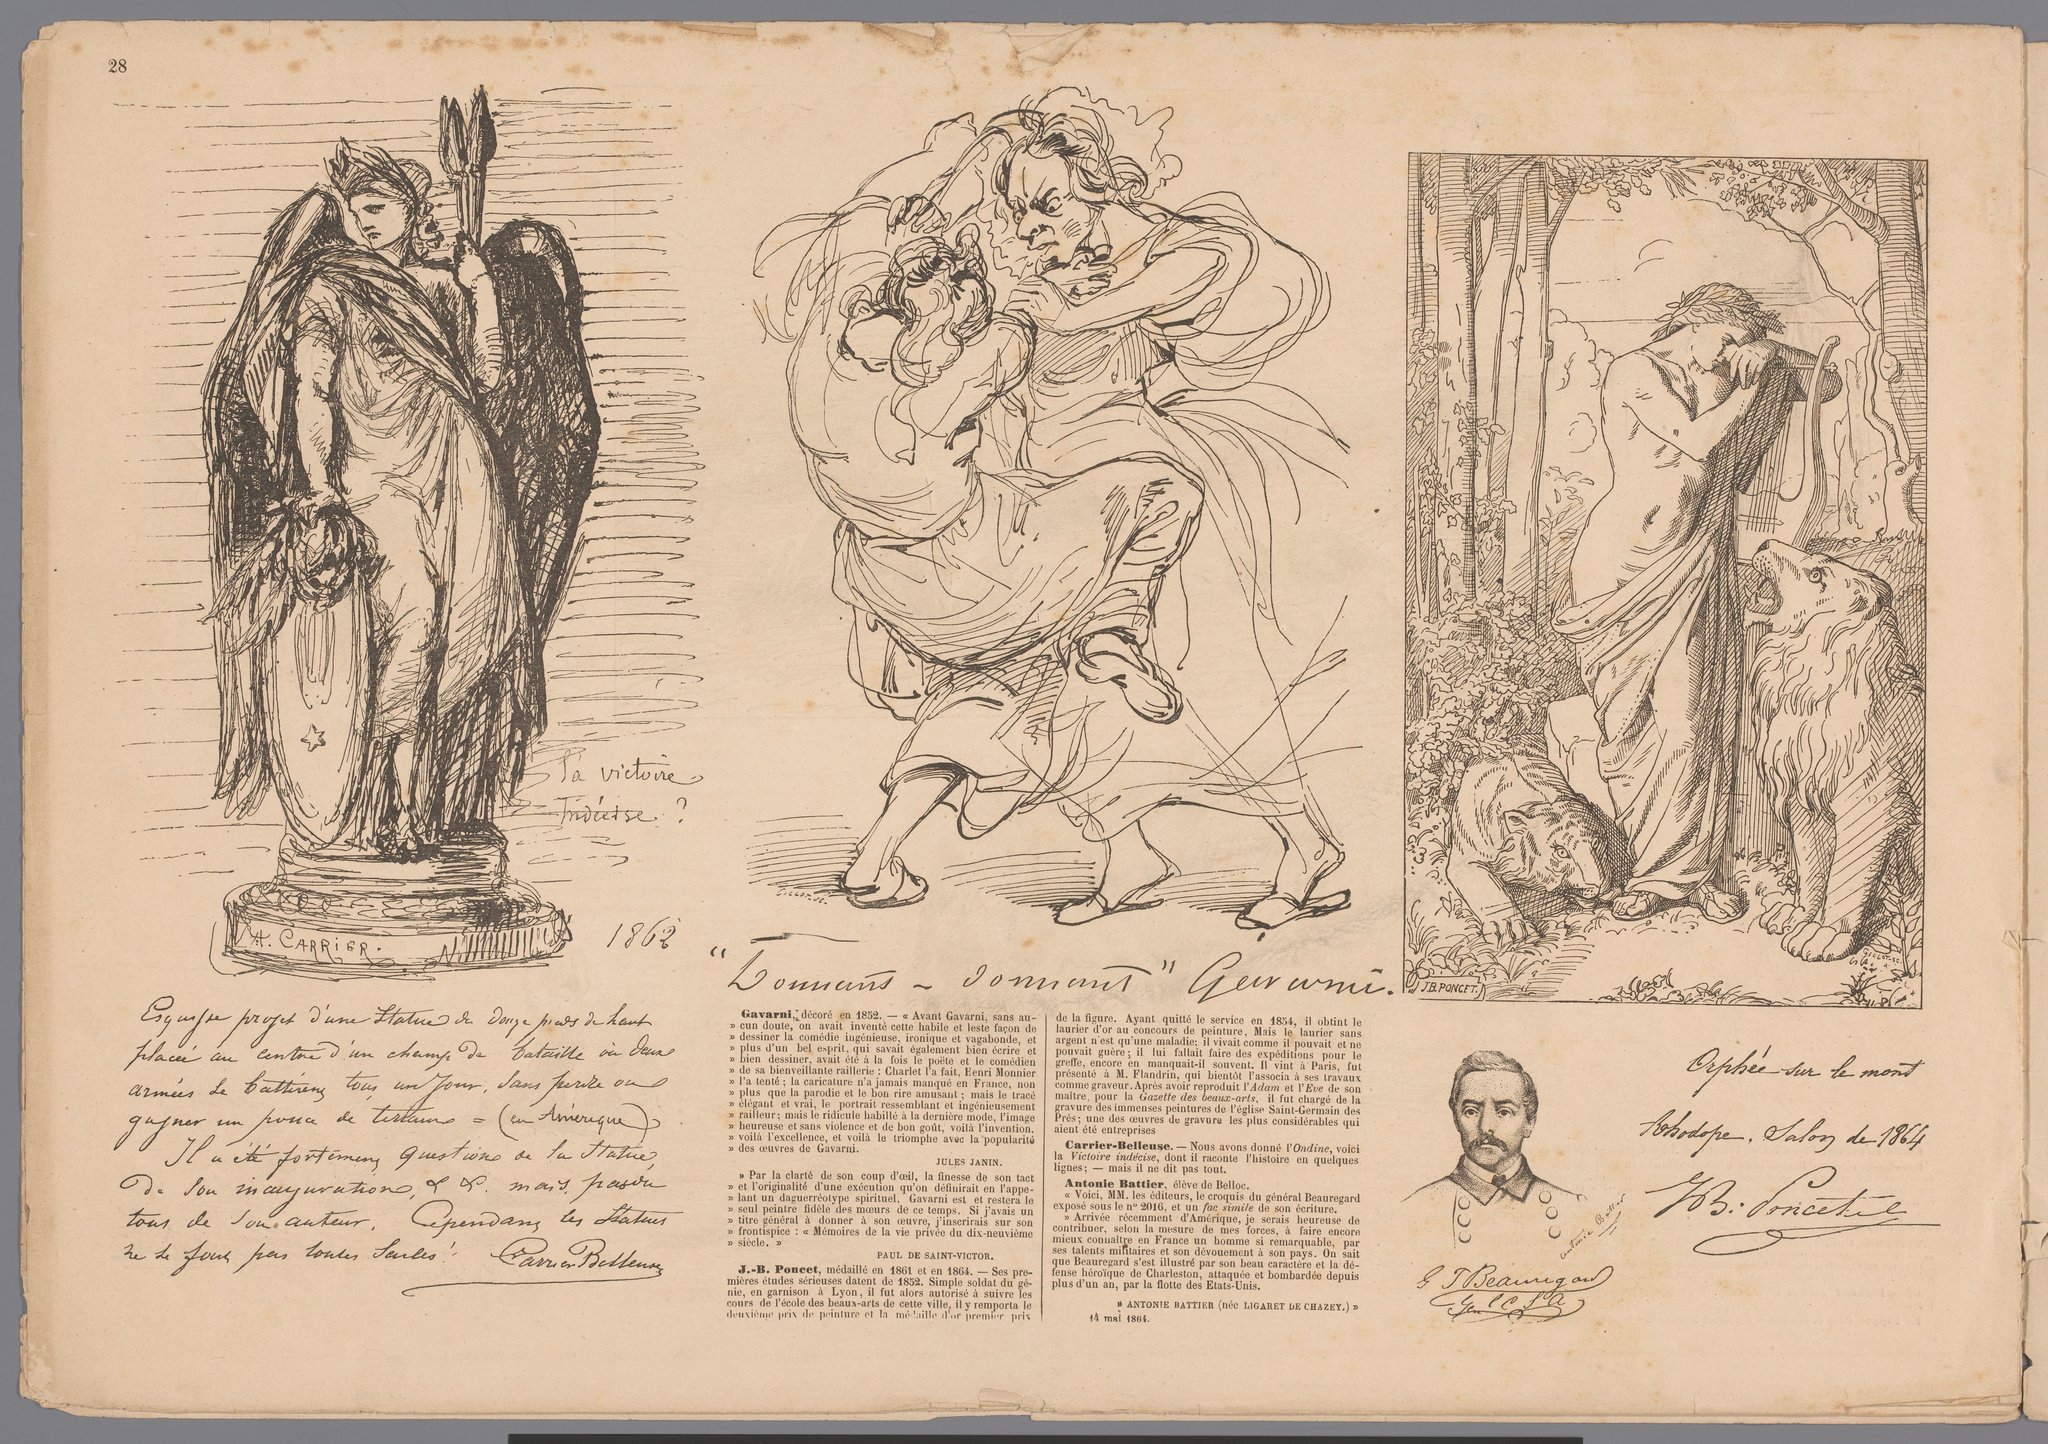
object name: print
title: Personificatie van de Overwinning, twee vechtende mannen, Orpheus en het hoofd van een man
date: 1864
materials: paper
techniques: gillotage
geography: paris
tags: 'victoria'; 'vittoria', 'vittoria navale', 'vittoria degl'antichi' (ripa), (story of) orpheus, fighting